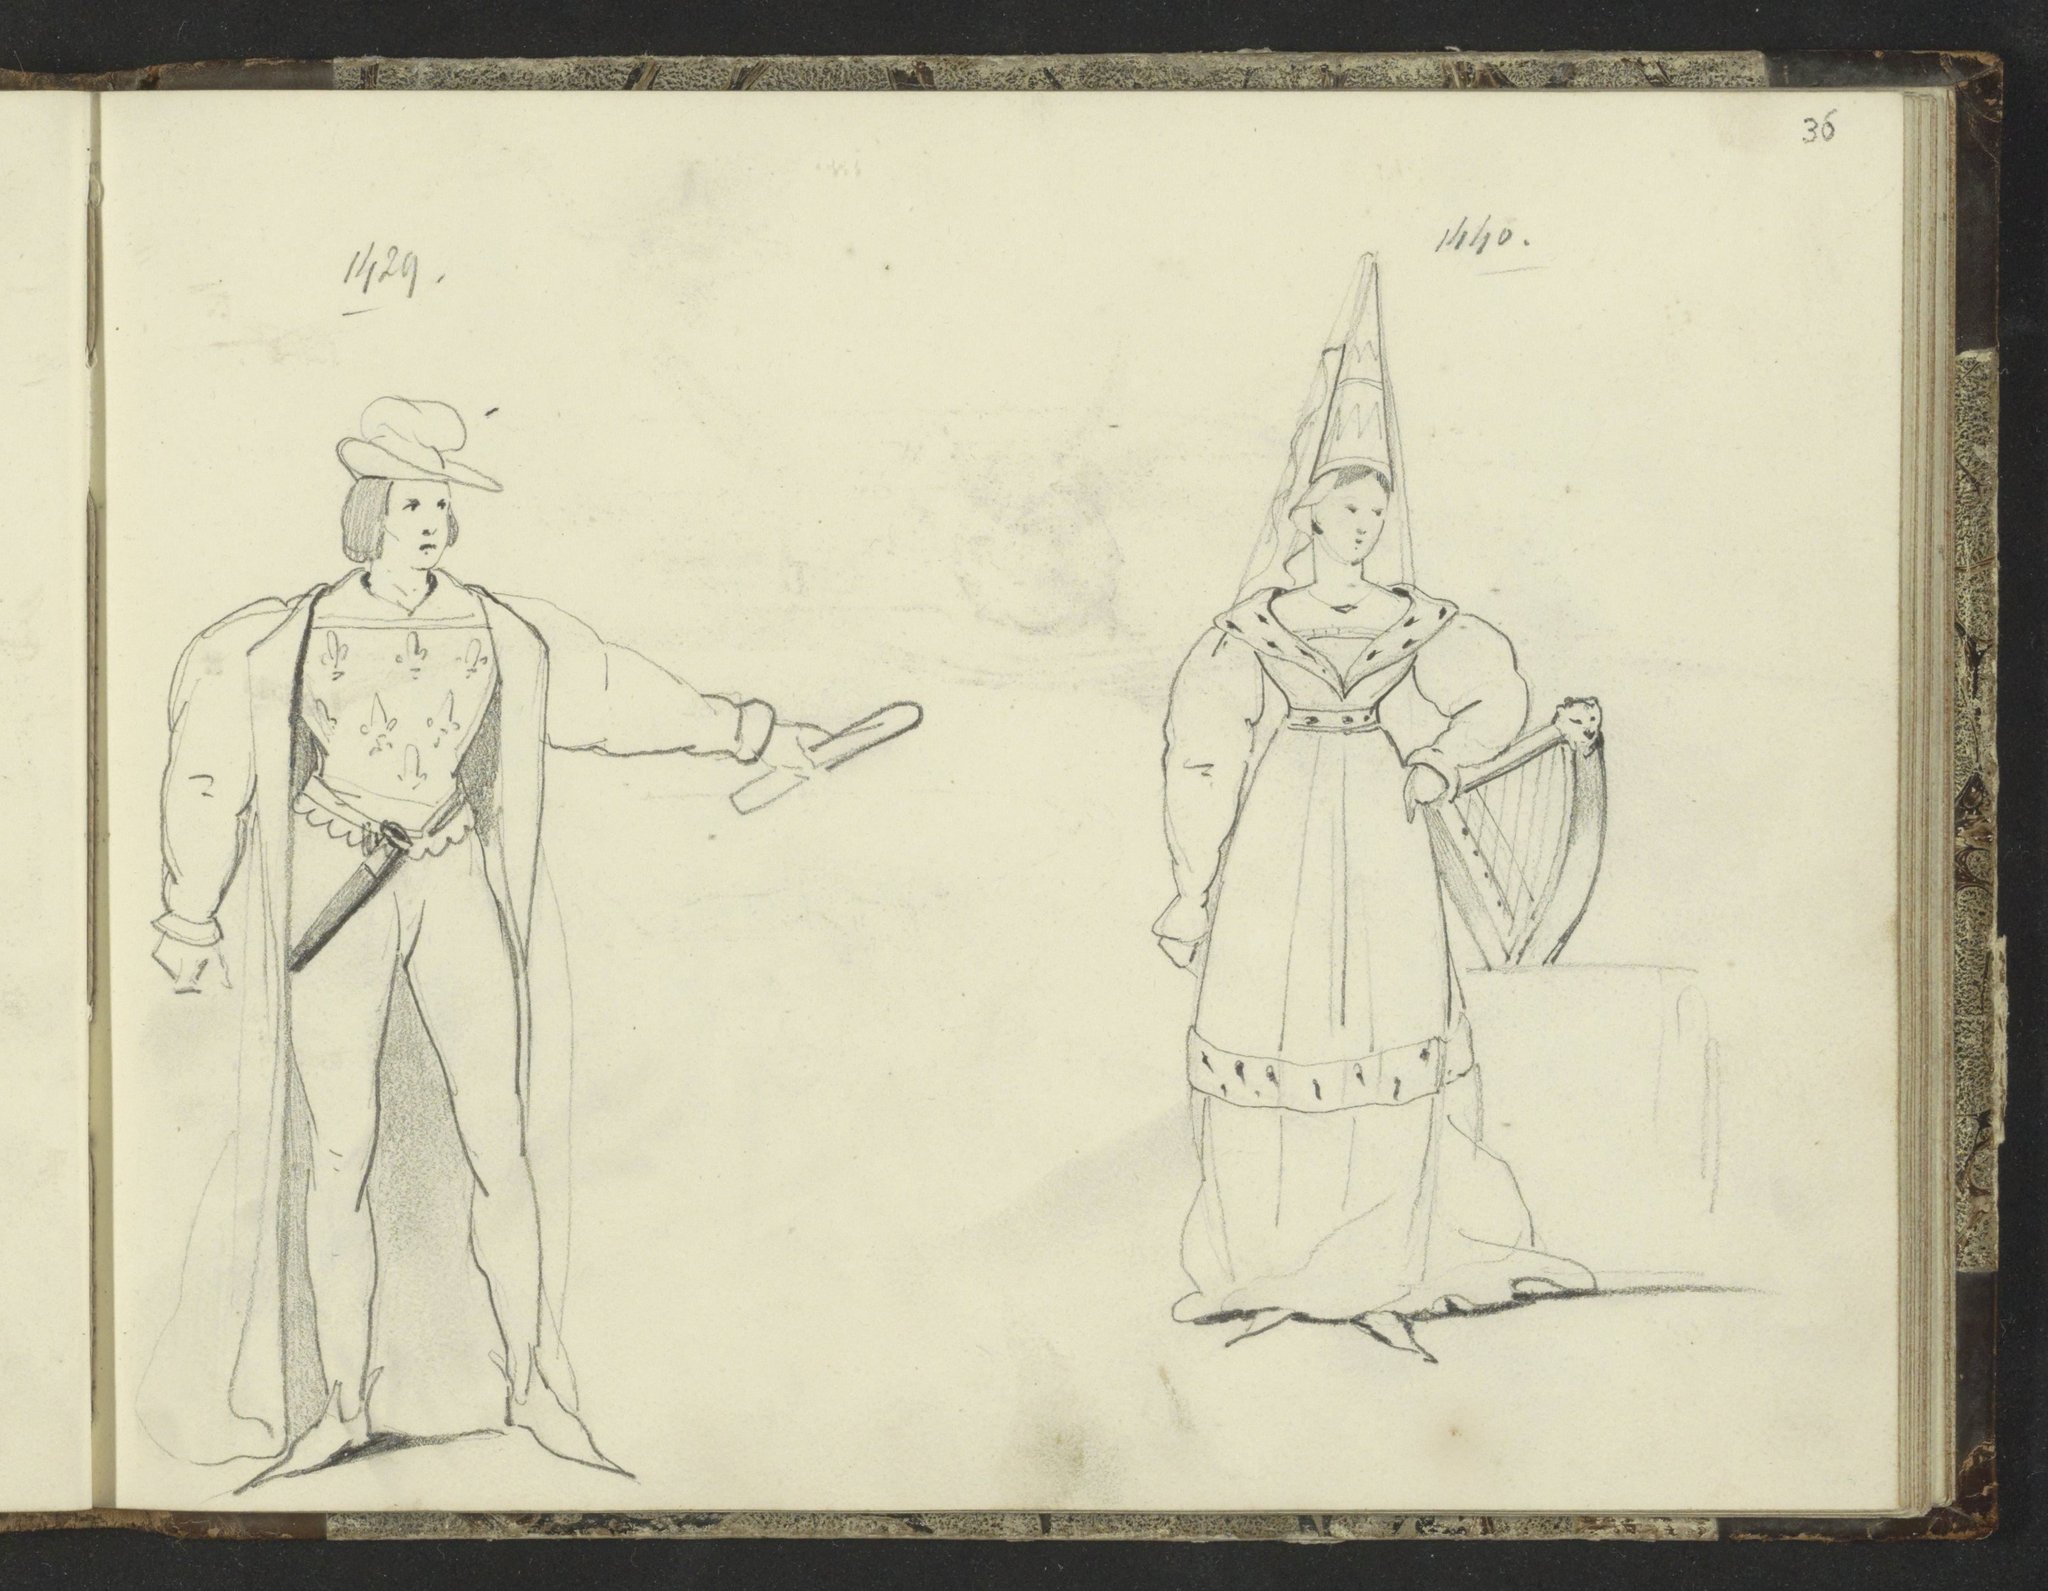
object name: sketchbook leaf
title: Man met dolk en vrouw met harp in vijftiende-eeuws kostuum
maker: willem hendrik schmidt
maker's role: draughtsman, painter, print maker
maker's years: 1809-1849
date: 1819-1849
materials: paper, pencil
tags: harp, historical costume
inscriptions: annotation: ‘1429./ 1440.’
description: Blad 36 recto uit een schetsboek met 58 bladen.